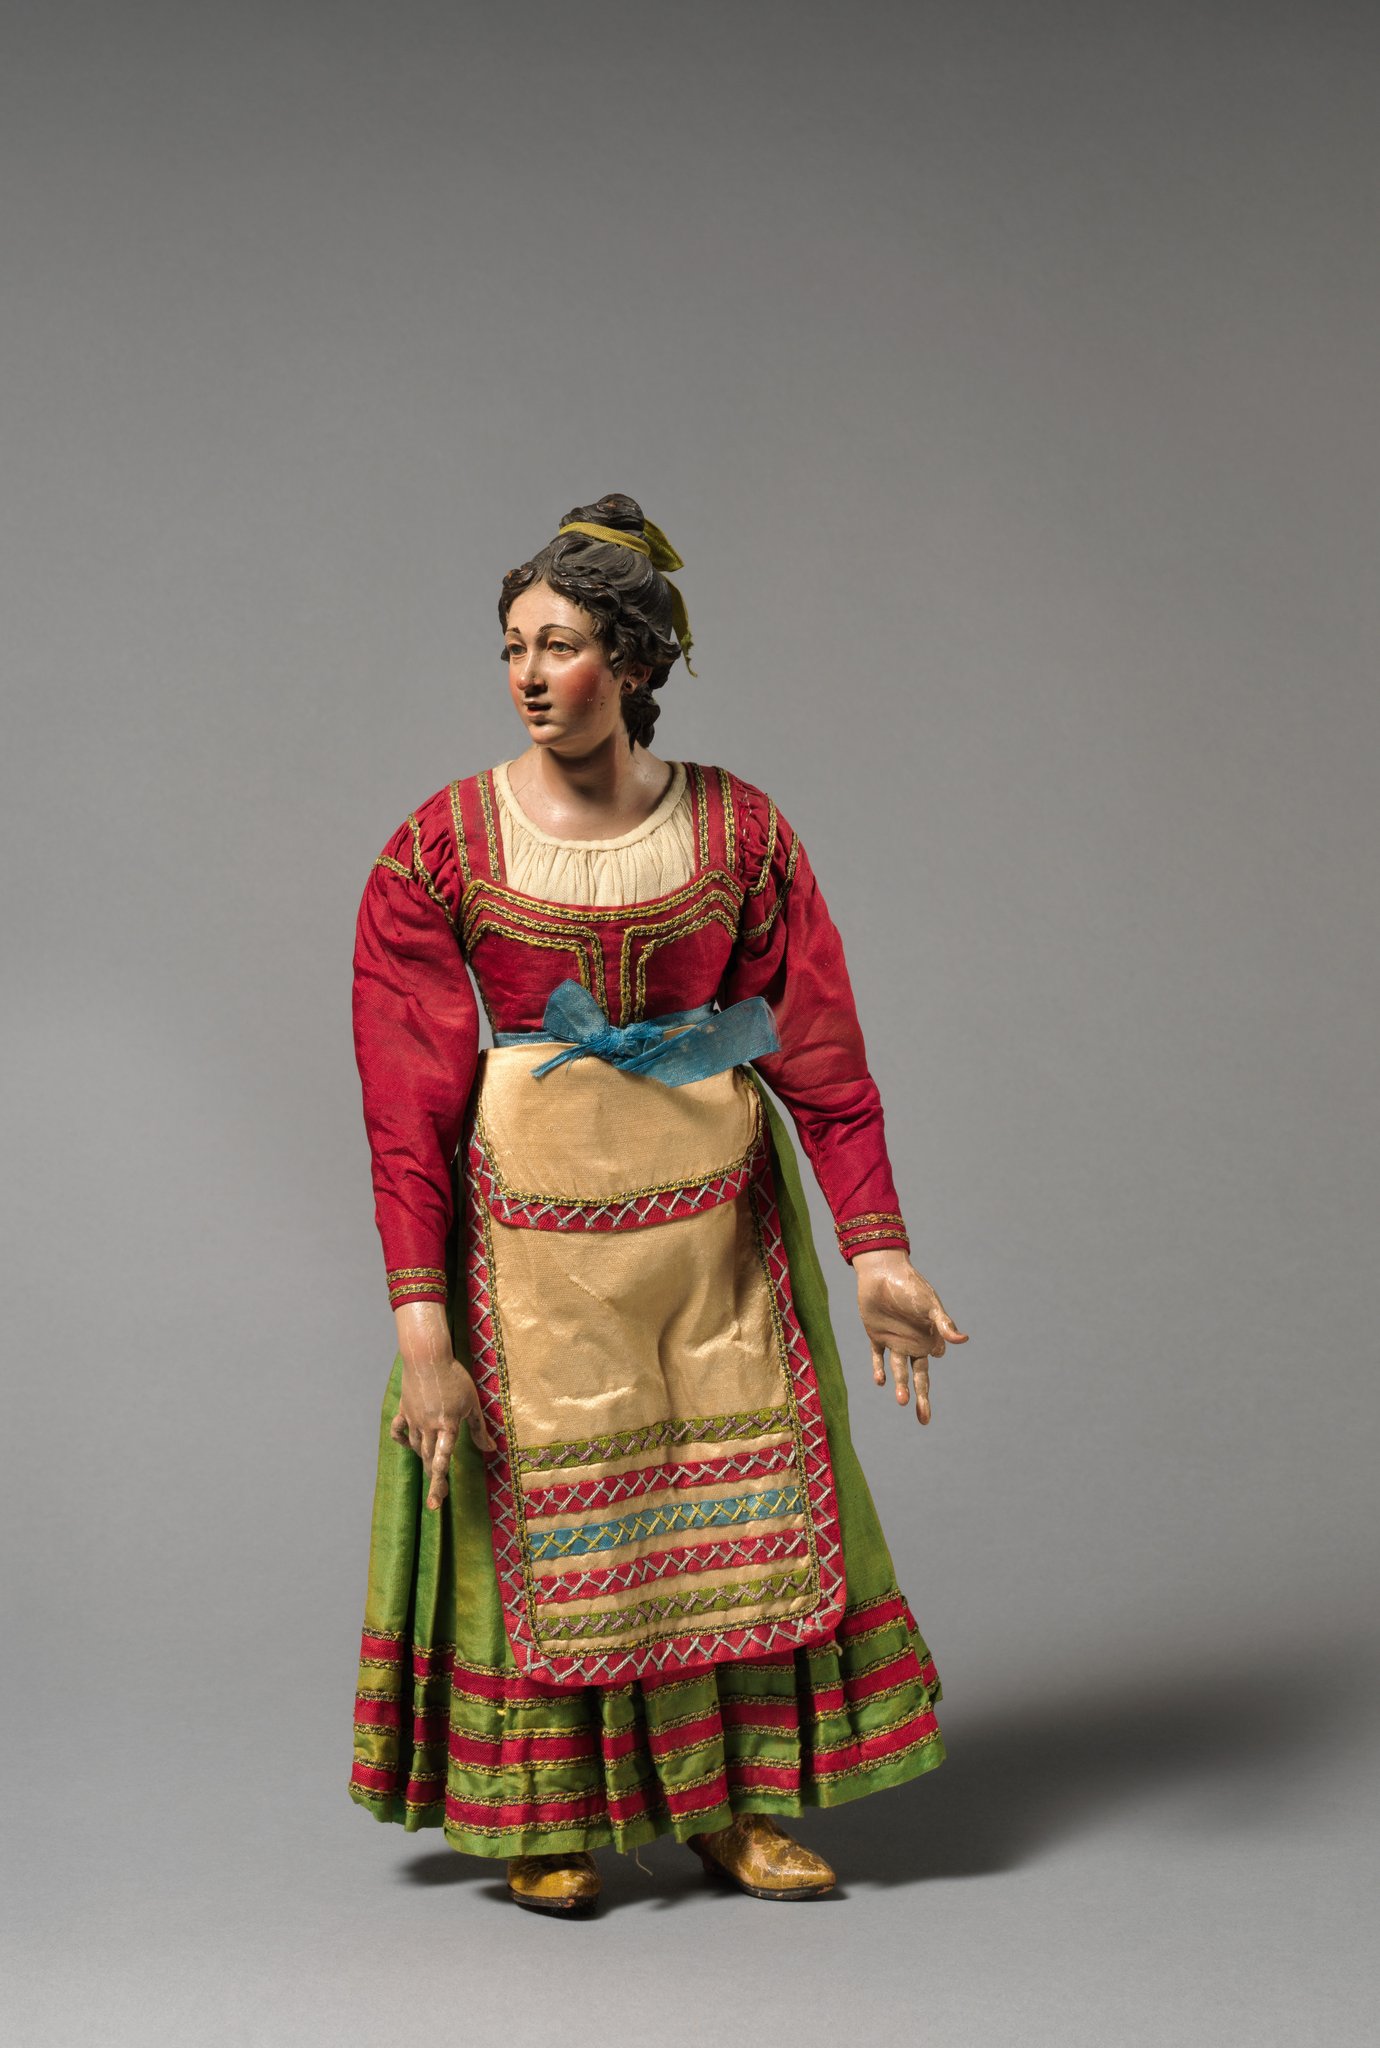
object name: crèche figure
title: Young woman looking up in red top, green skirt, cream apron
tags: women